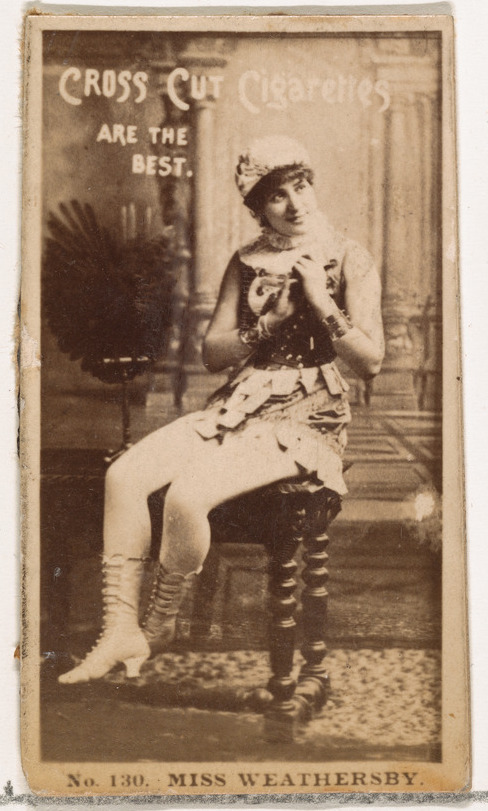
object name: print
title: Card Number 130, Miss Weathersby, from the Actors and Actresses series (N145-2) issued by Duke Sons & Co. to promote Cross Cut Cigarettes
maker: w. duke, sons & co.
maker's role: publisher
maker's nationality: american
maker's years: 1870-1920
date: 1880-1889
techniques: albumen silver print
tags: portraits,women,actresses